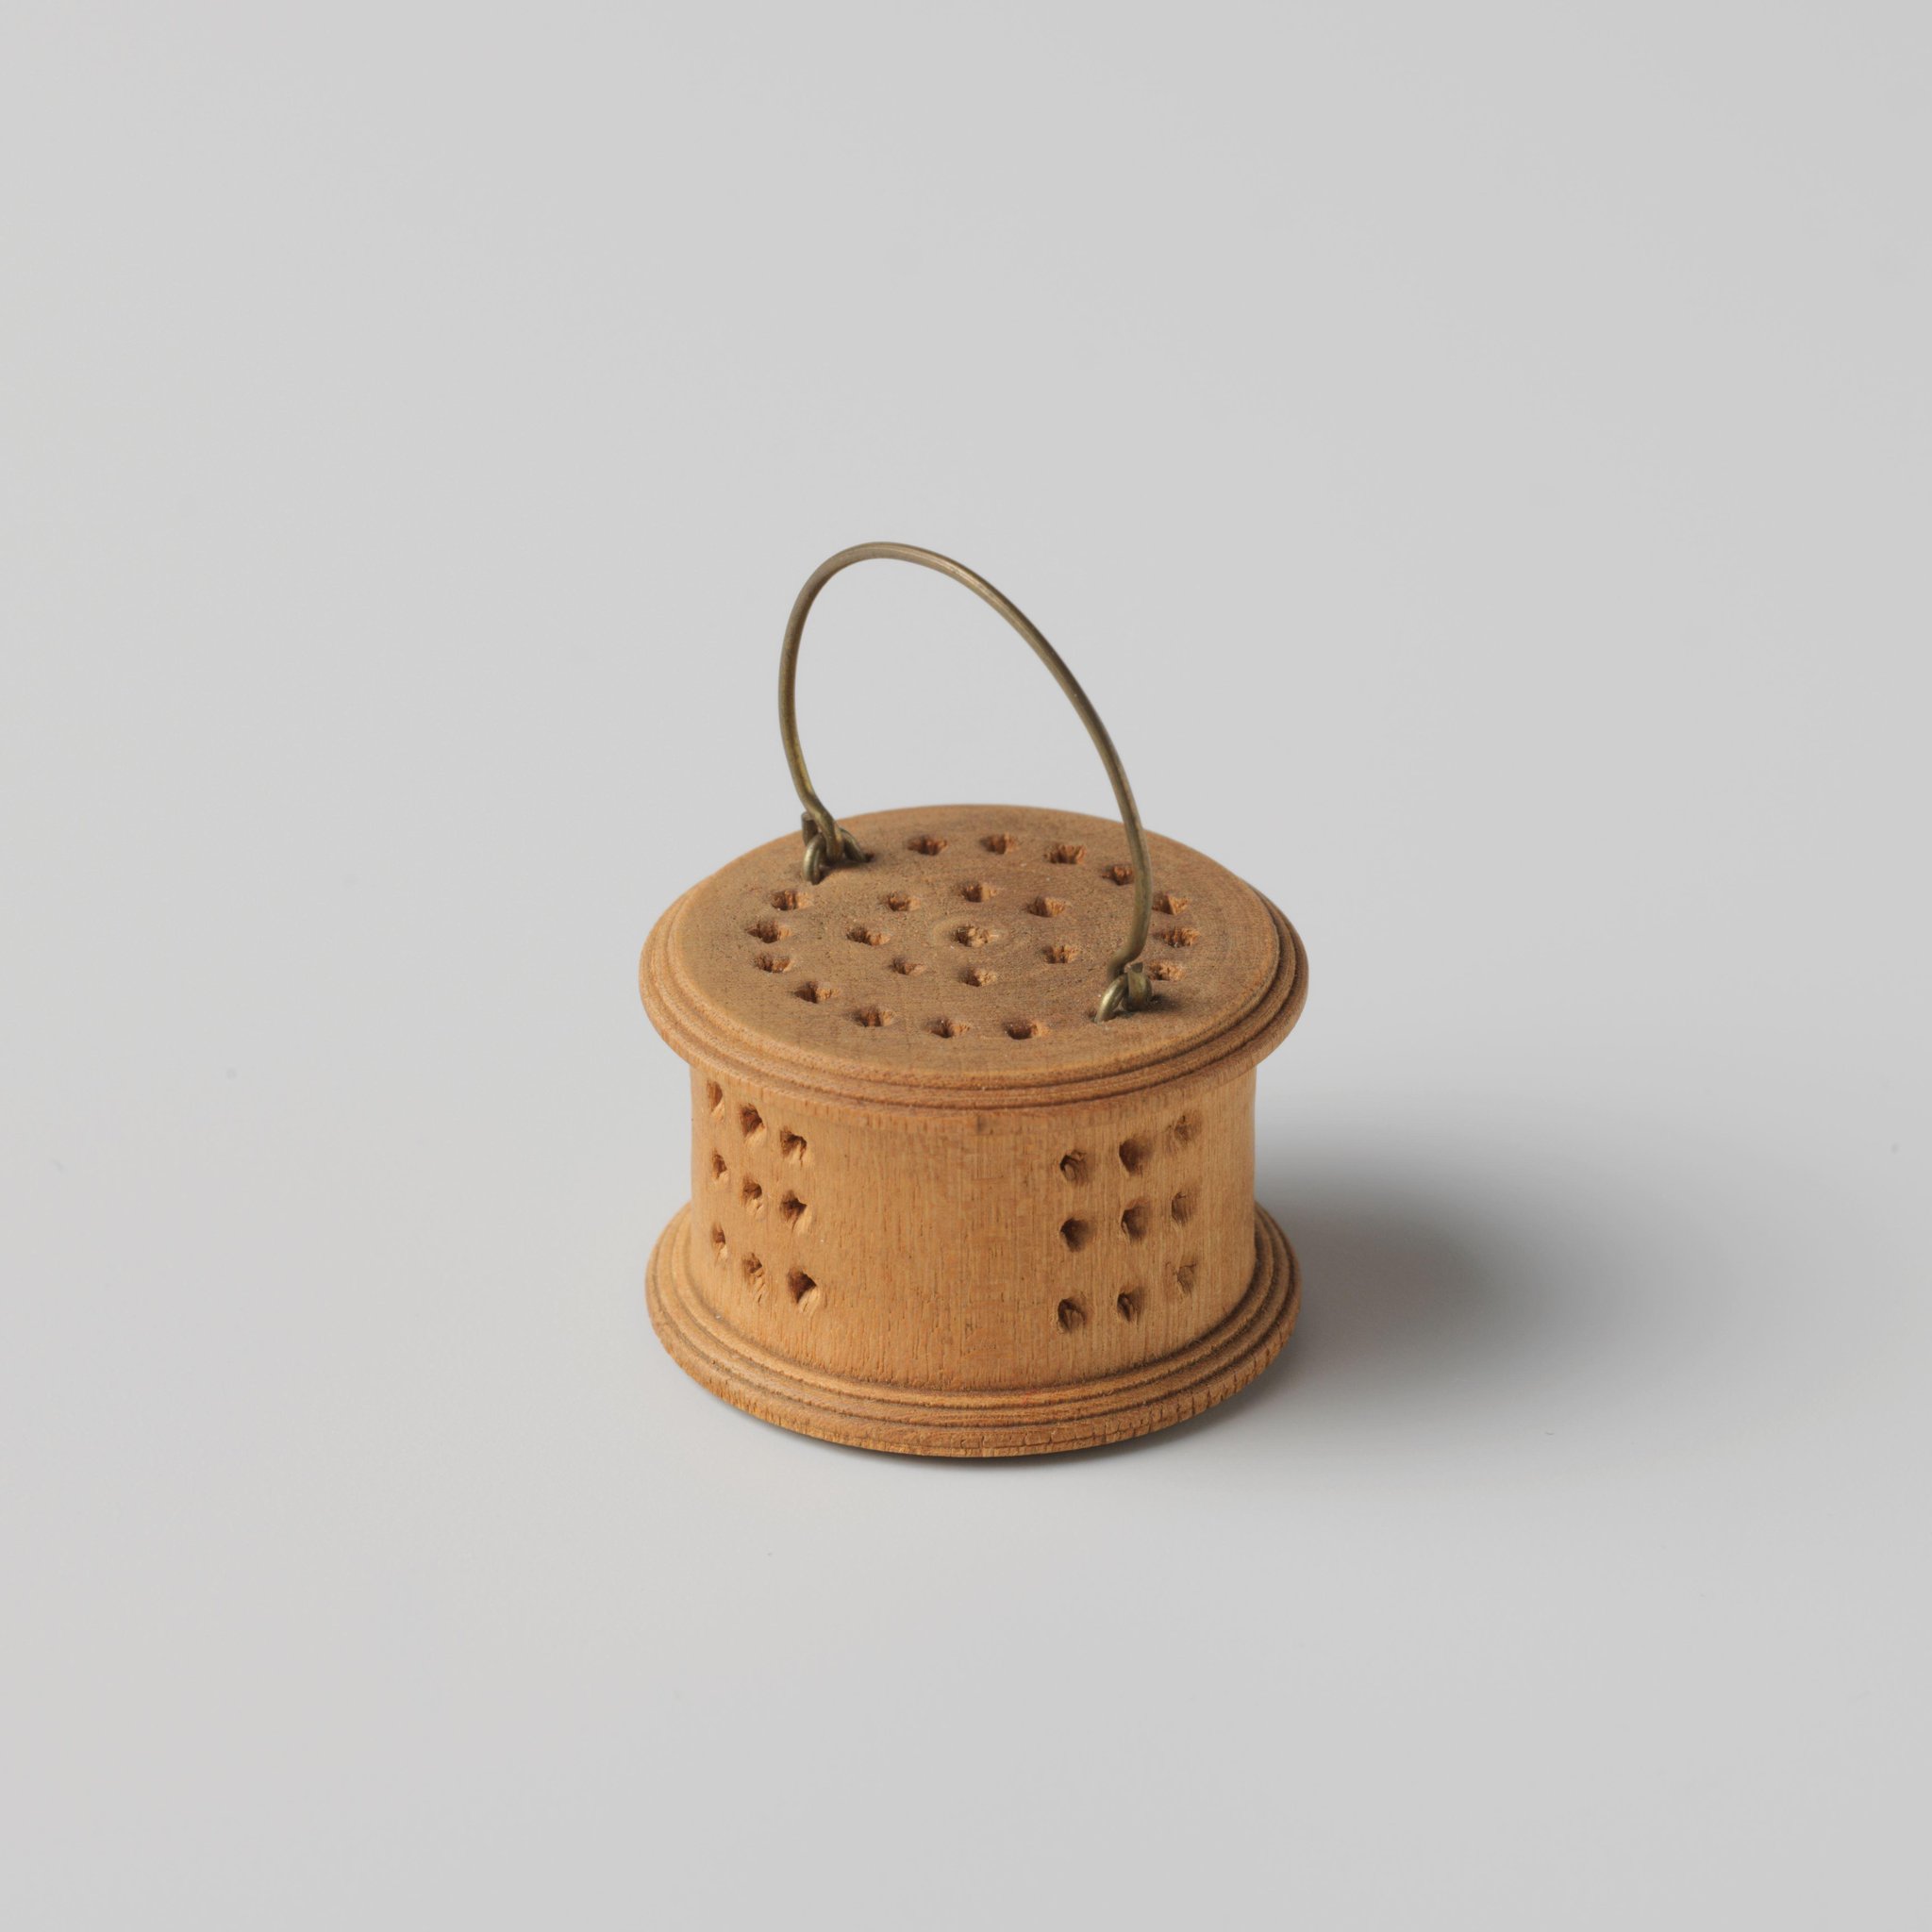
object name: voetstoof, stoof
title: Stoof, rond, met tweeentwintig gaten in de bovenzijde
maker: Anonymous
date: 1800-1899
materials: wood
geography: netherlands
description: Stoof, rond, van massief esdoornhout met rondom vier keer negen gaten en bovenin tweeentwintig gaten ingeboord; hengsel van koperdraad.